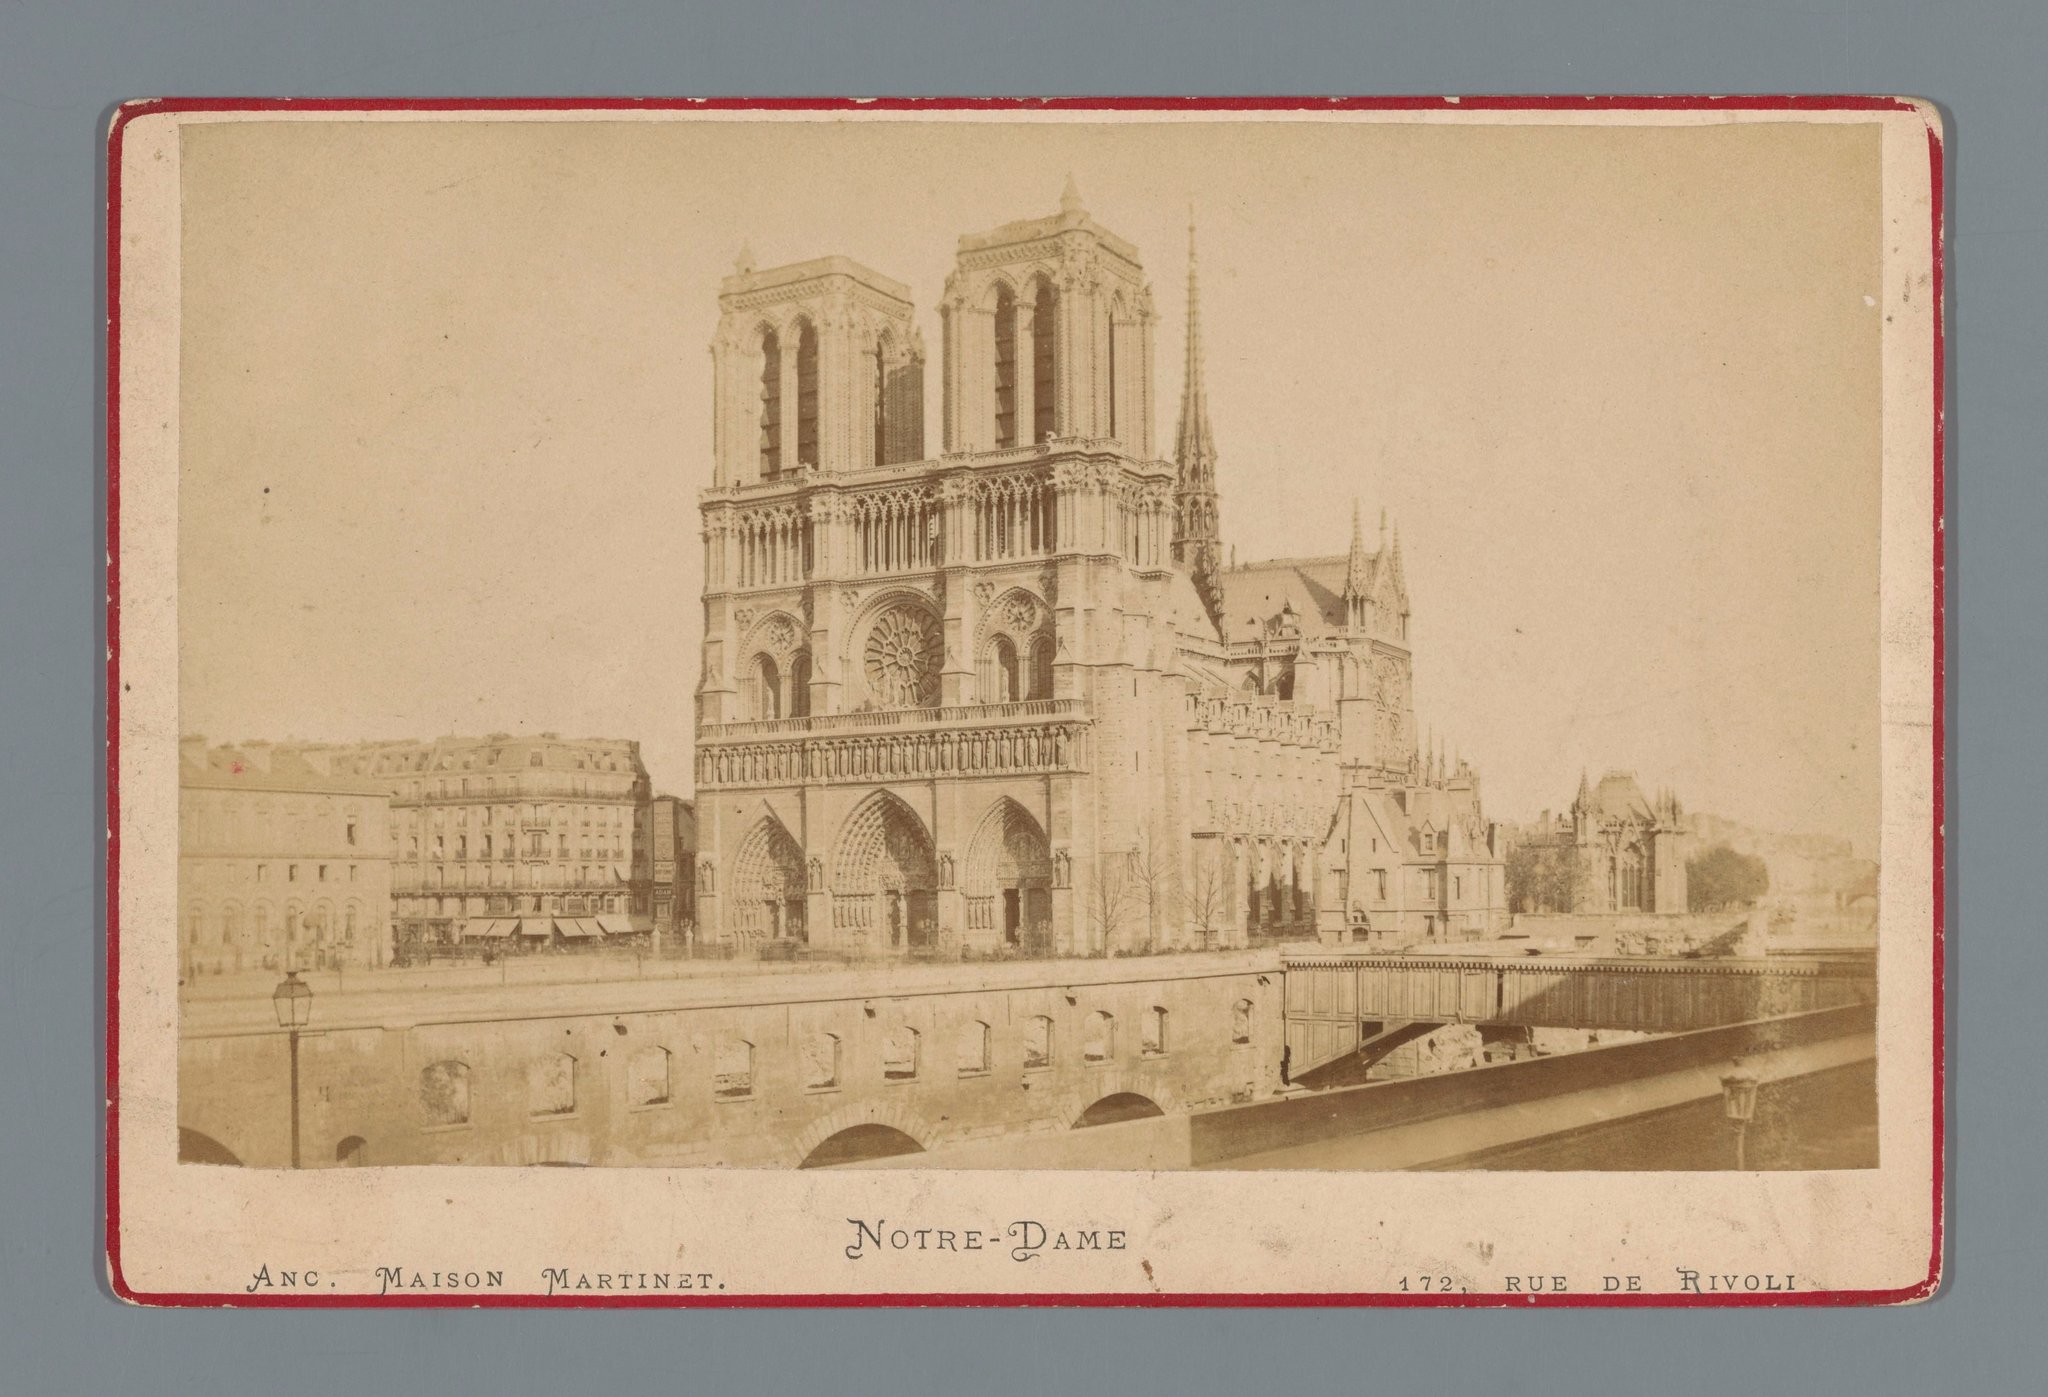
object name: photograph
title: Notre-Dame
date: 1860-1890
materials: cardboard, photographic support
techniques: albumen print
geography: paris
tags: city-view in general; 'veduta', church (exterior), façade (of house or building)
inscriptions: address: ‘172, rue de Rivoli’